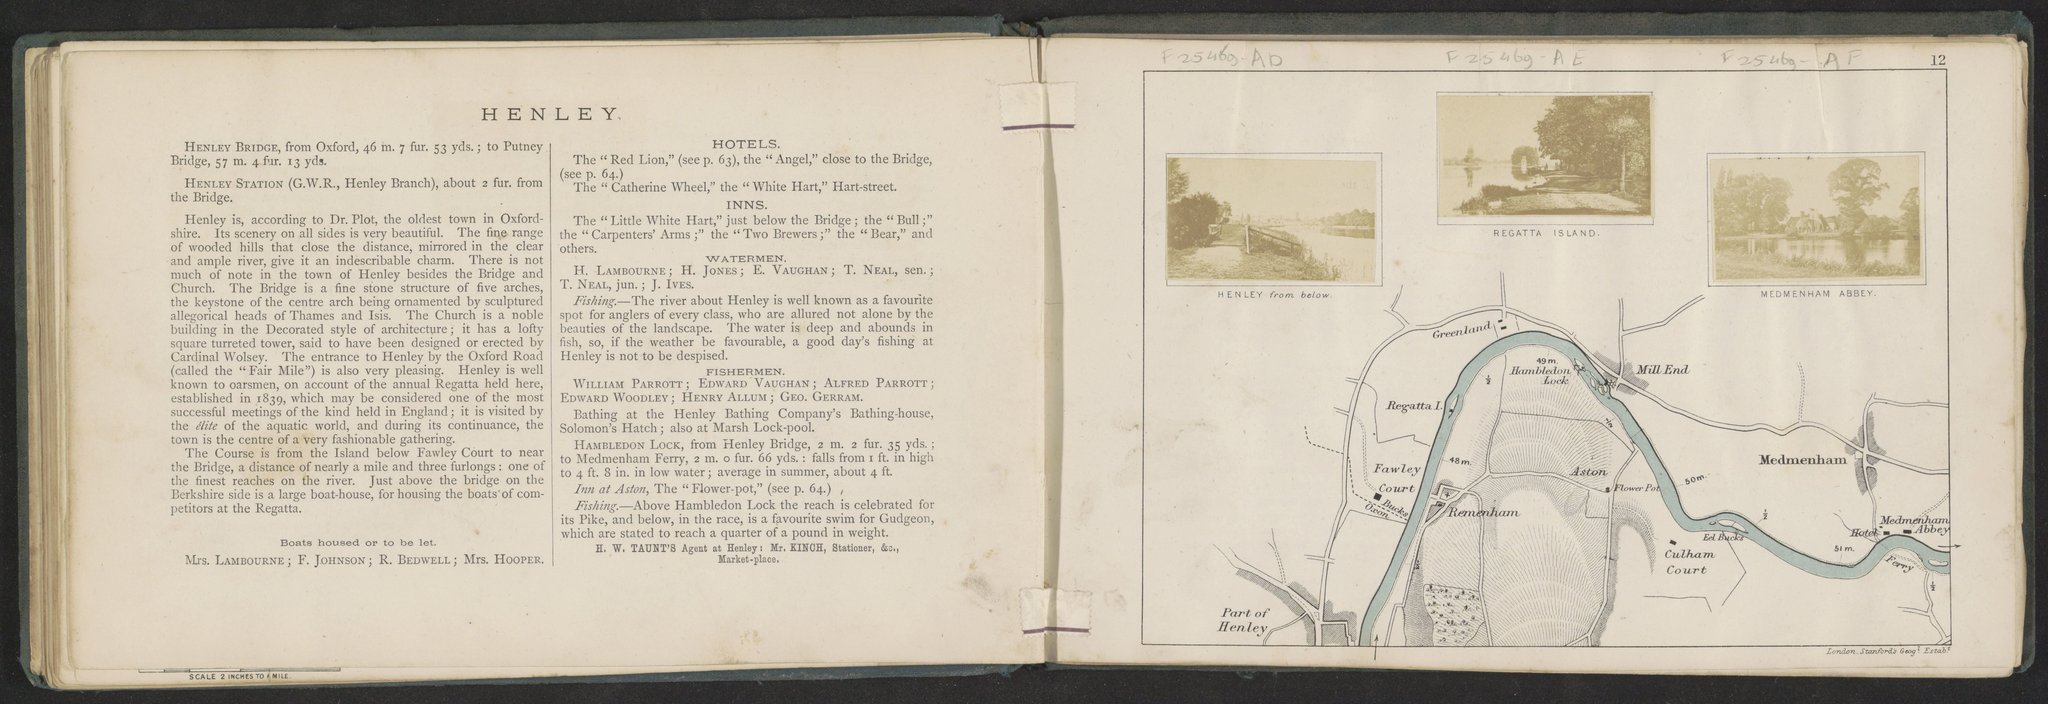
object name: page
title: Medmenham abbey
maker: henry w. taunt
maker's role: fotograaf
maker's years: 1842-1922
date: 1871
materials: photographic support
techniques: albumen print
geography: medmenham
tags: river, abbey, monastery, convent ~ roman catholic church, thames